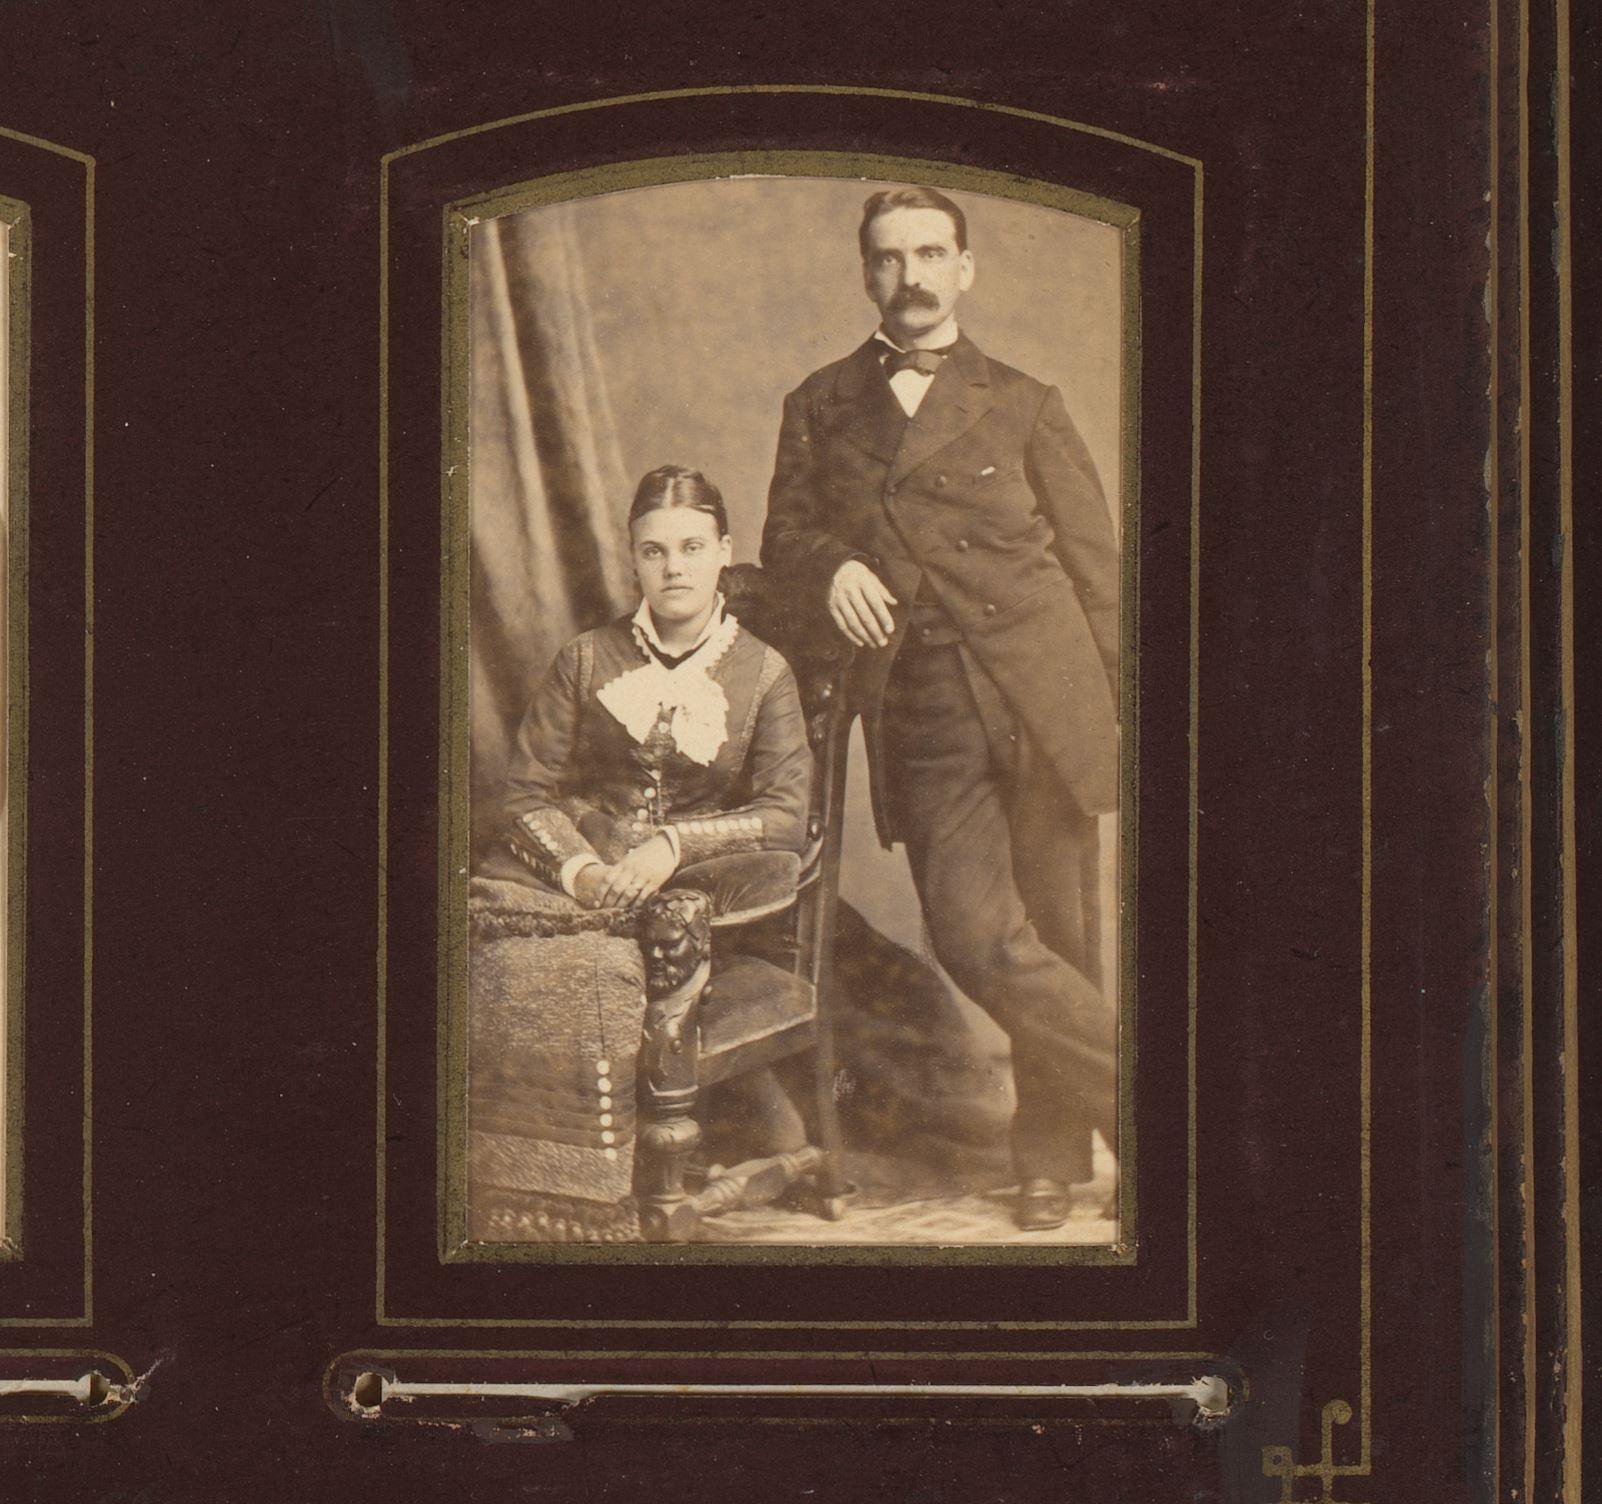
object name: album leaf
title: Portret van een zittende vrouw en een staande man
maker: a. böeseken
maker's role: fotograaf, lithograaf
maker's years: 1834-1919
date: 1878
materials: cardboard, photographic support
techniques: albumen print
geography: rotterdam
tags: historical persons - bb - woman, historical persons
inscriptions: inscription: ‘A. Böeseken/ Photographisch Atelier/ Hoogstraat over de/ Vlasmarkt/ ROTTERDAM.’, annotation: ‘Aan mijn vriendin/ Catharina van der/ Meulen. Tot/ herinnering, bij mijn/ vertrek naar/ Indië./ Merina Schrieller/ van den em[.]/ Barendrecht/ 8 October 1878.’